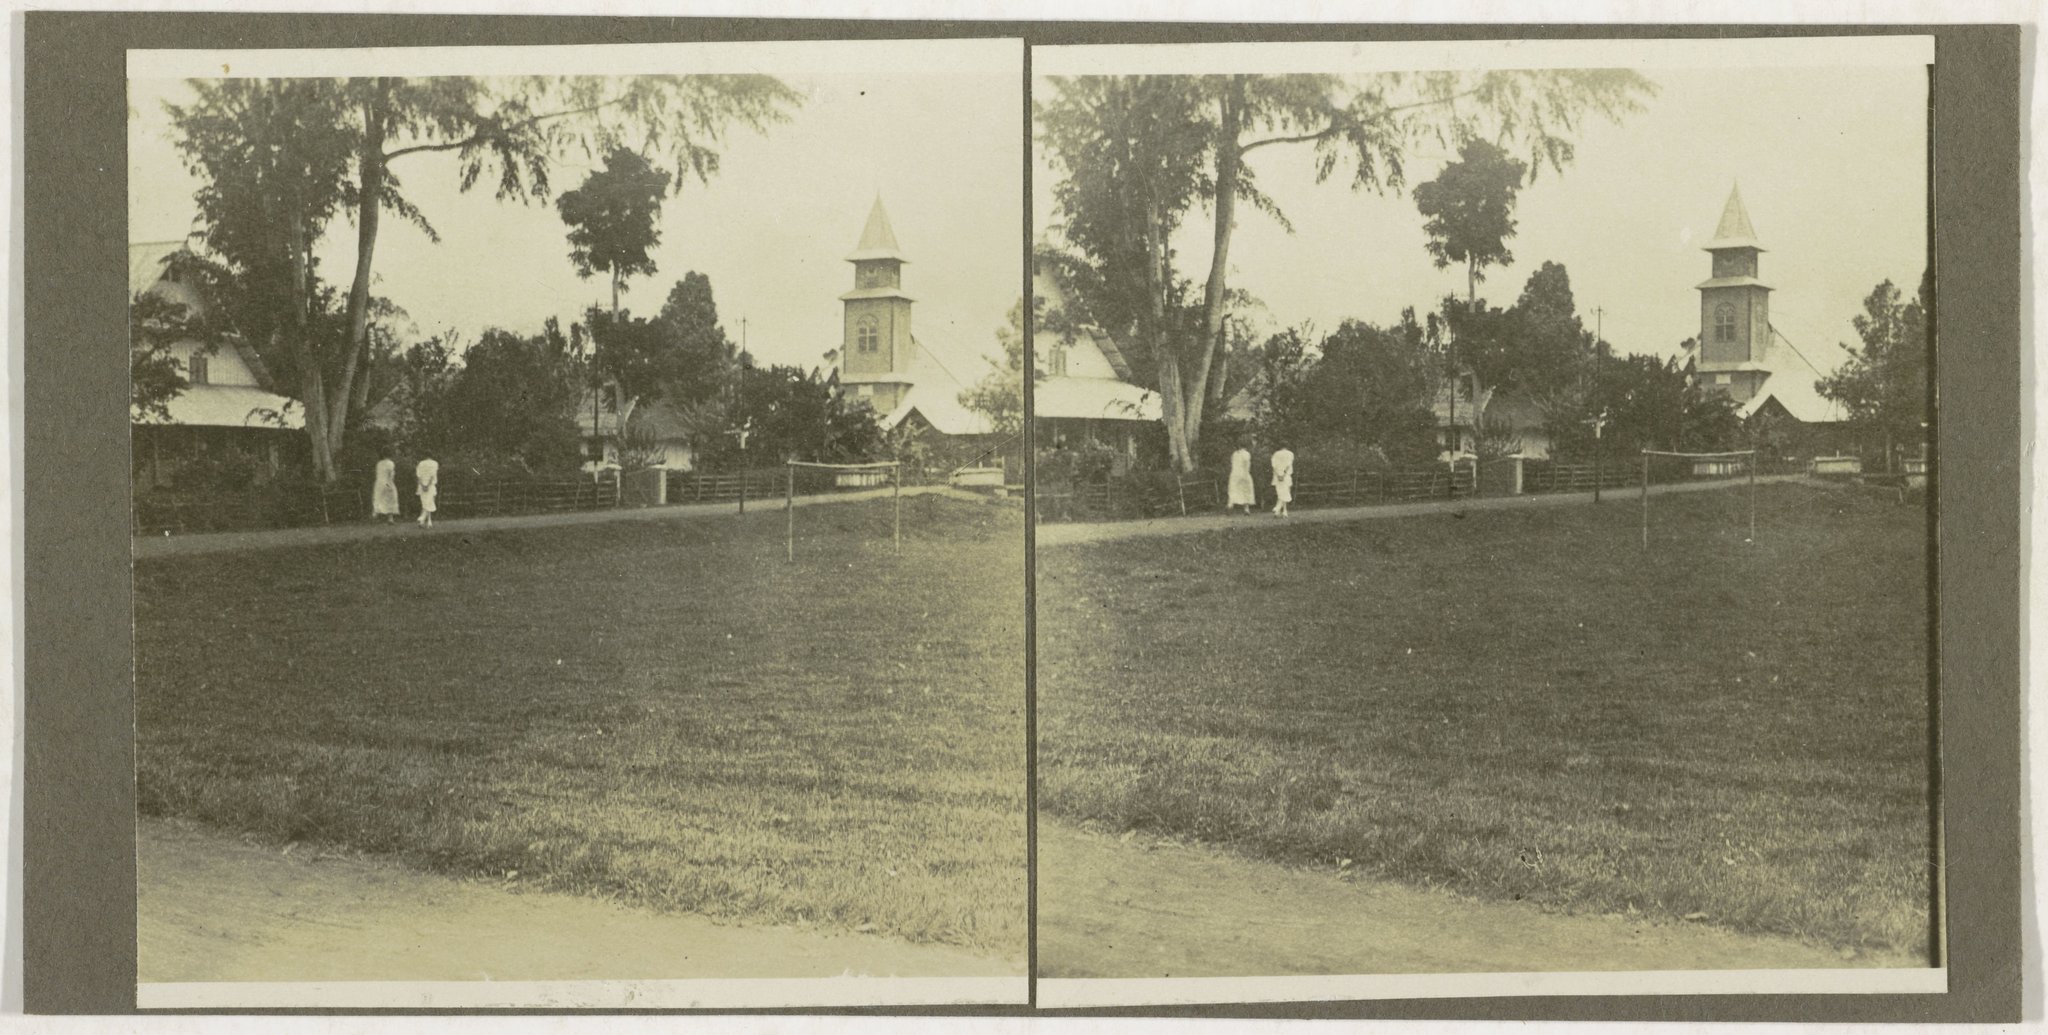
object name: stereograph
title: Pad naar een kerk met twee mensen in Tondano, Indonesië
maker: Anonymous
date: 1900-1940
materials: paper, cardboard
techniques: gelatin silver print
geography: tondano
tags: village street, roman catholic church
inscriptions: inscription: ‘Minahasja (Manado)/ Tondano’